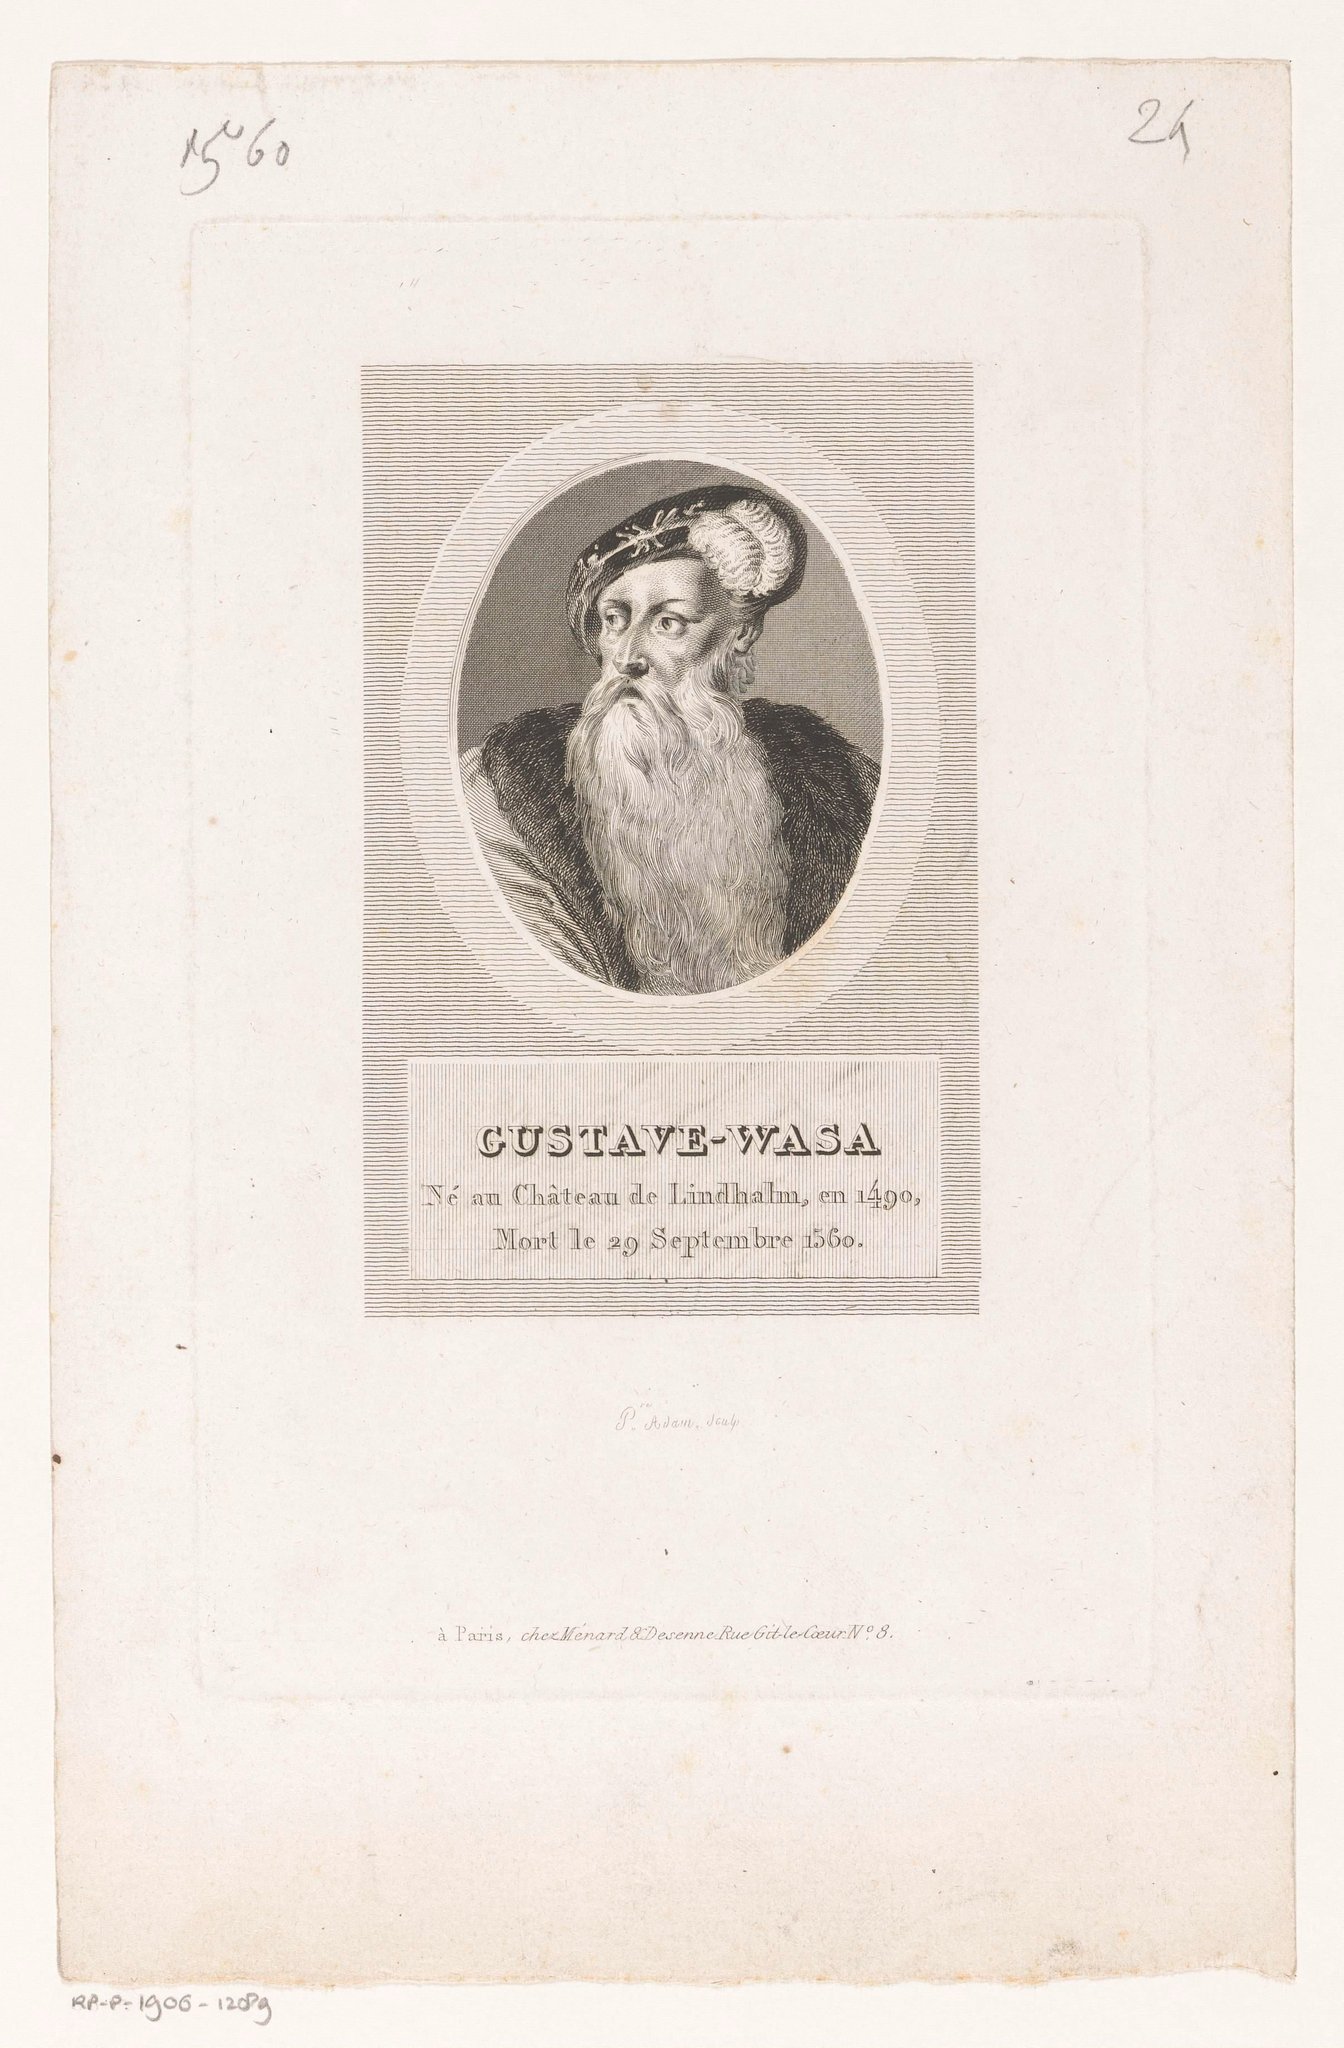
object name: print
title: Gustave-Wasa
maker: pierre michel adam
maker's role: print maker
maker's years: 1799-1853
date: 1810-1853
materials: paper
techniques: etching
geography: paris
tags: historical persons, ruler, sovereign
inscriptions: collector's mark: Lugt 2228